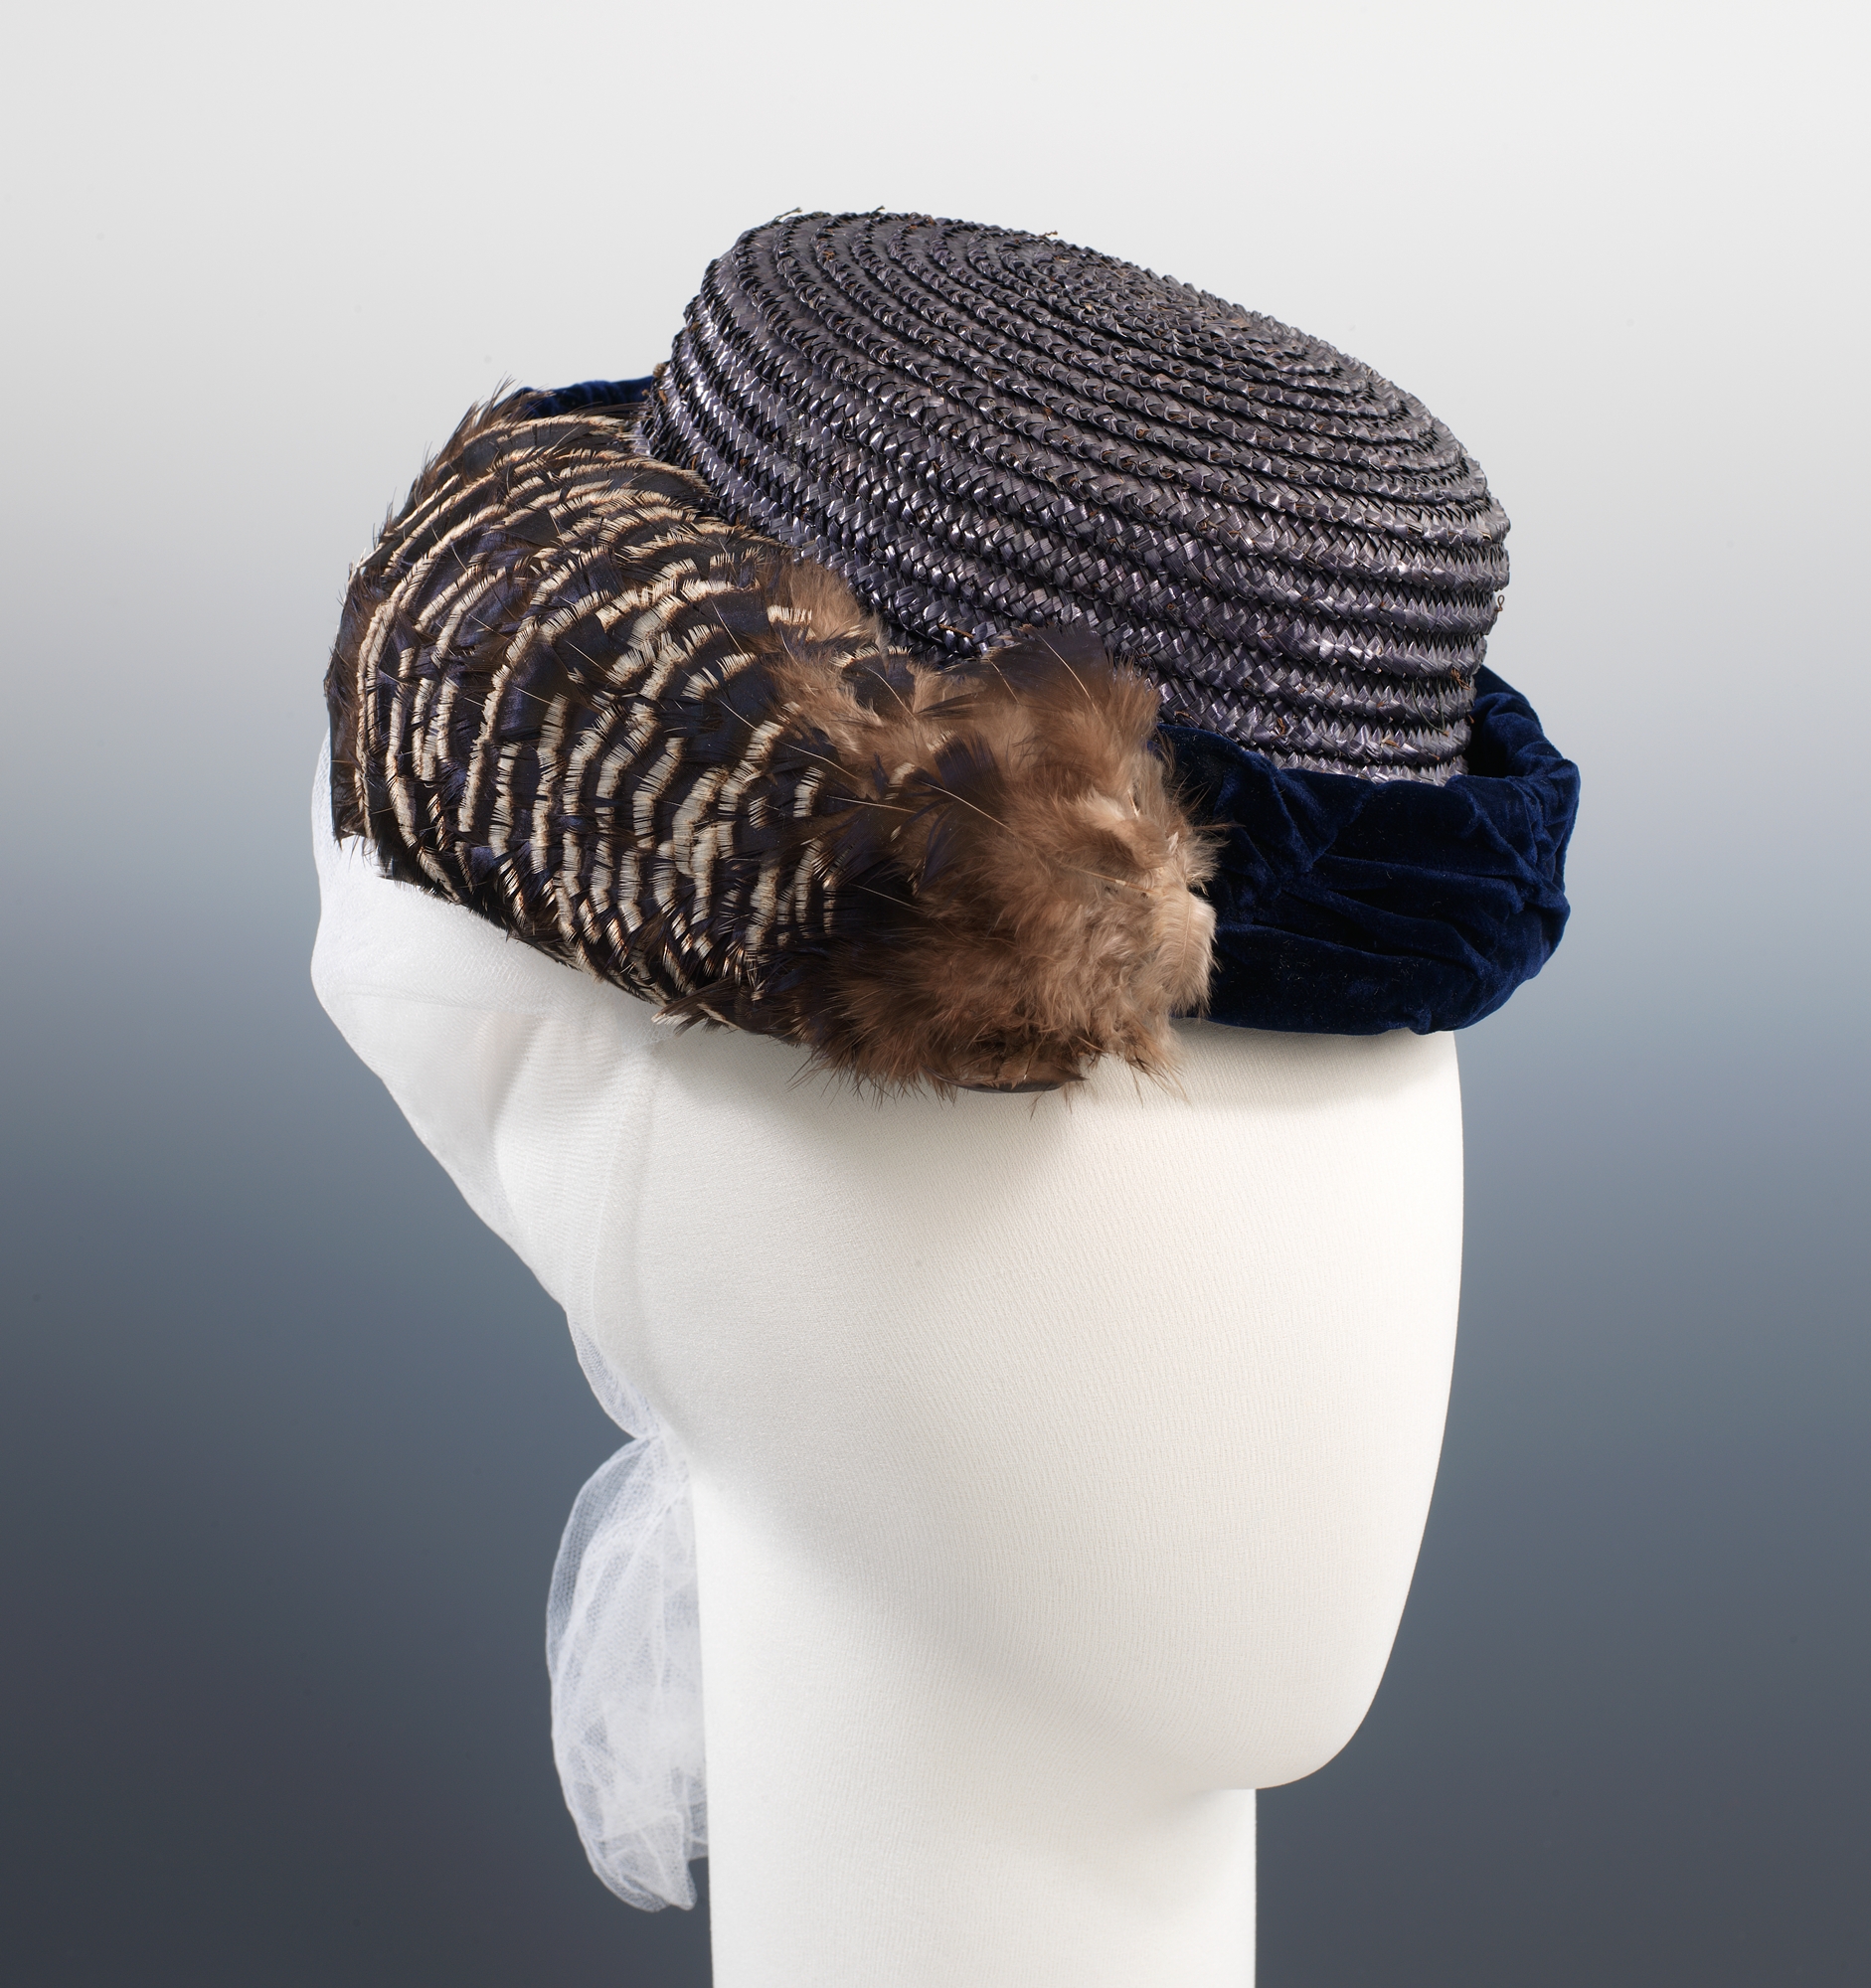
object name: hat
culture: british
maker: william charles brown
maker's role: designer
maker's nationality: british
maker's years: 1800-1899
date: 1870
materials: feather, silk, fiber